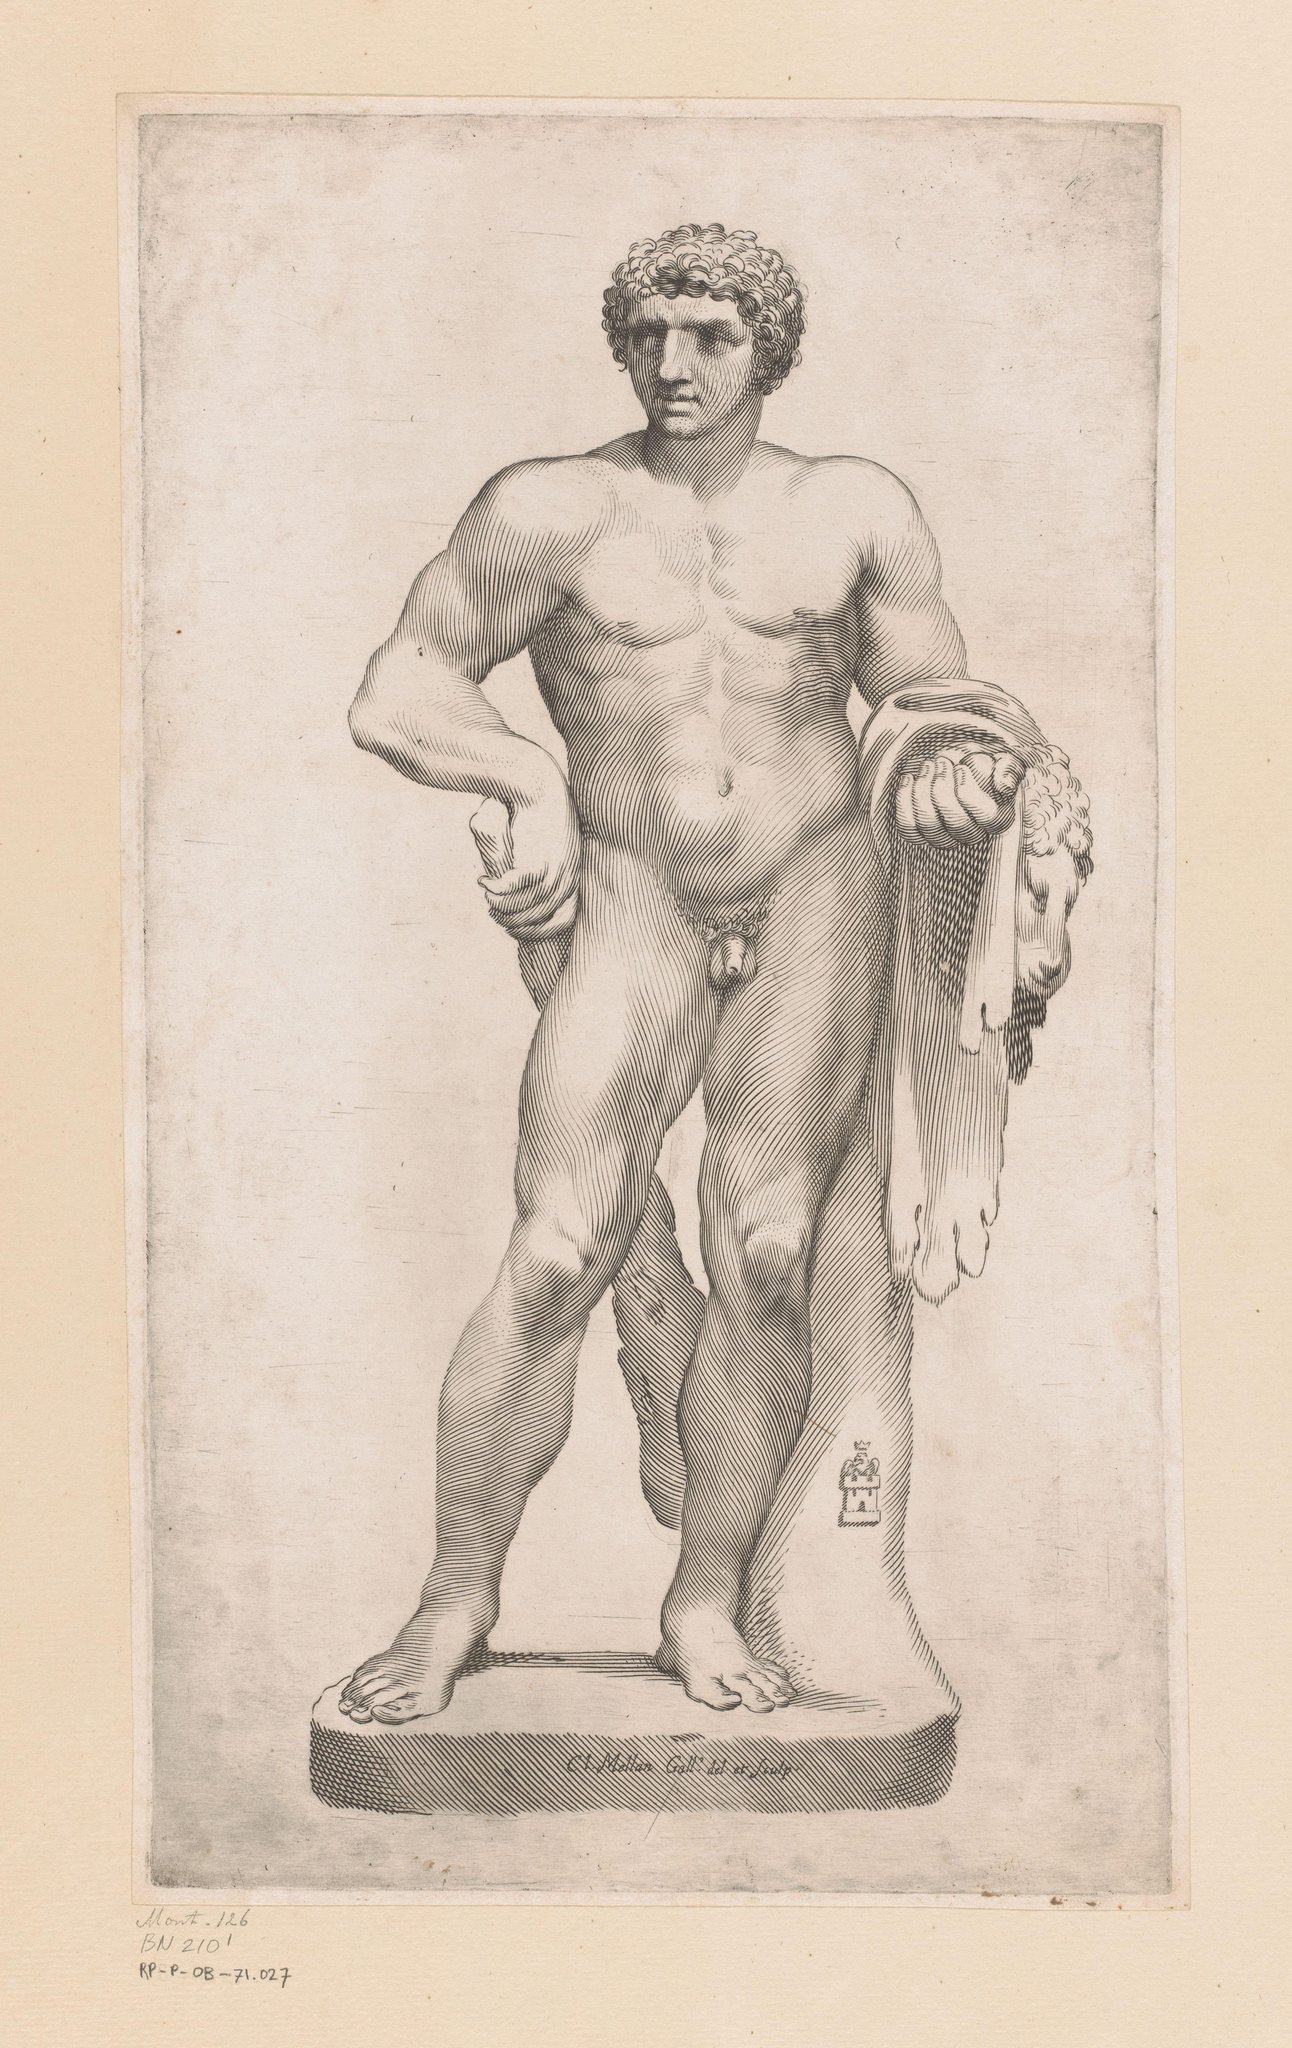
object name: print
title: Galleria Giustiniana del Marchese Vincenzo Giustiniani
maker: claude mellan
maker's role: draughtsman, print maker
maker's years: 1598-1688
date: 1631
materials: paper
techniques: engraving, intaglio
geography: rome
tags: (story of) hercules (heracles), piece of sculpture, reproduction of a piece of sculpture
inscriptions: collector's mark: Lugt 240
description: Maakt deel uit van een serie bestaande uit 322 prenten van kunstwerken uit de collectie van Vincenzo Giustiniani die in twee volumes werd uitgegeven door Joachim von Sandrart in 1636 en 1637 (zie British Museum, inv.nr. 1851,1213.565). De serie bestaat uit prenten door verschillende kunstenaars zoals Cornelis Bloemaert, Theodore Matham, Pieter de Bailliu en Michel Natalis. Claude Mellan was verantwoordelijk voor 22 prenten van standbeelden en het 1631 gedateerde portret van Giustiniani.